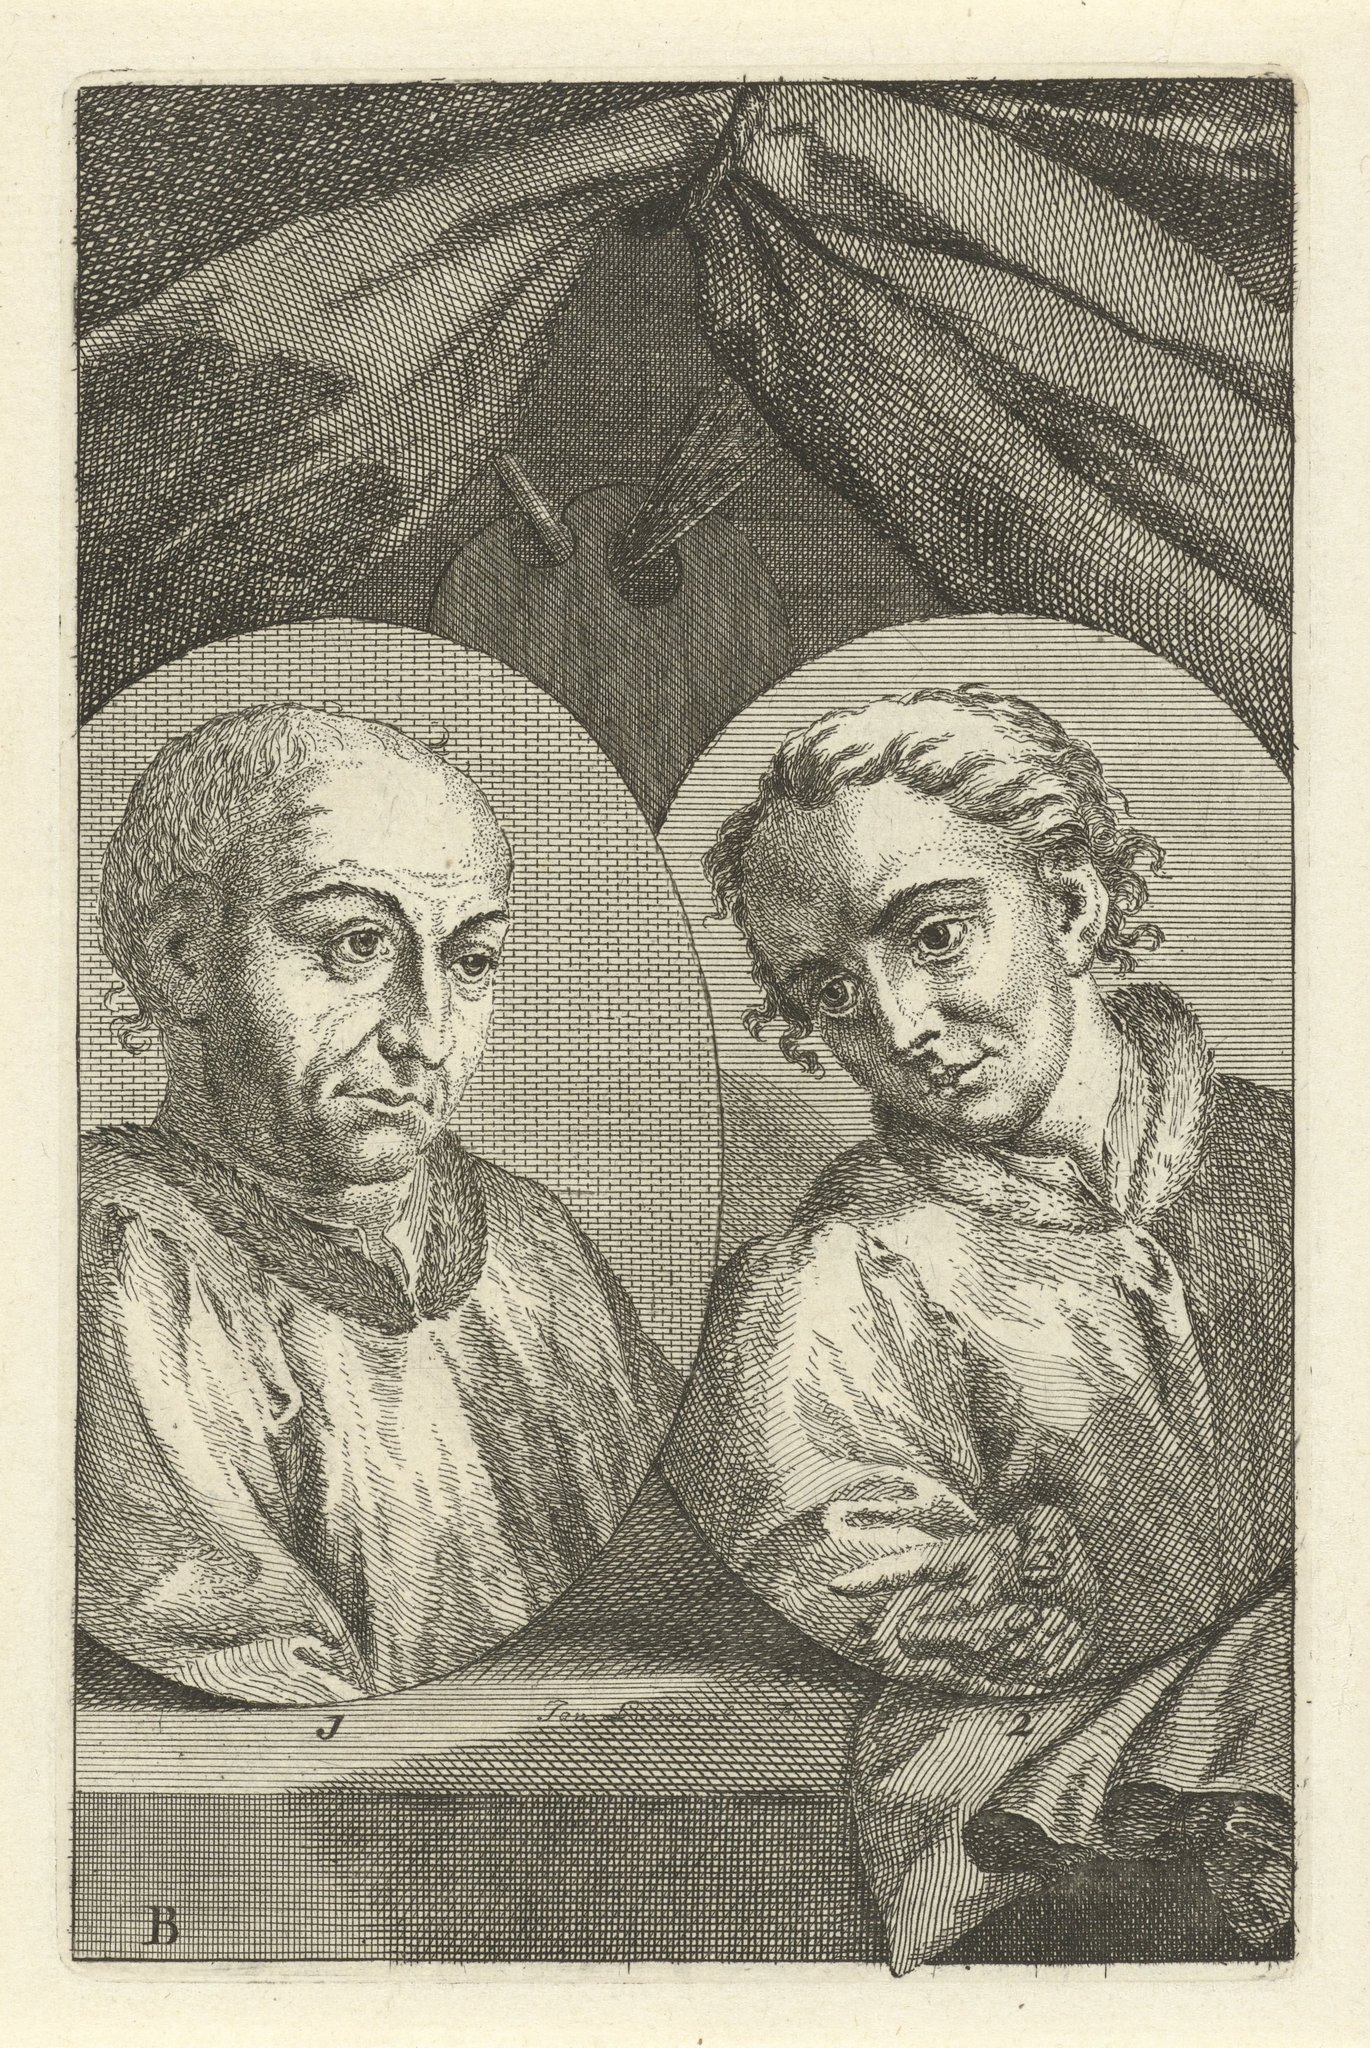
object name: print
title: Dubbelportret van Jan en Hubert van Eyck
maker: jan l admiral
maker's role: draughtsman, print maker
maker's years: 1699-1773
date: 1764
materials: paper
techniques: etching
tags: bruges, draughtsman, jan van eyck, hubert van eyck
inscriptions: collector's mark: Lugt 2228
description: Prent opgenomen in: Mander, Karel van; Jongh, Jacobus de (vert.). Het leven der doorluchtige Nederlandsche en eenige Hoogduitsche schilders. Amsterdam: Steven van Esveldt, 1764.